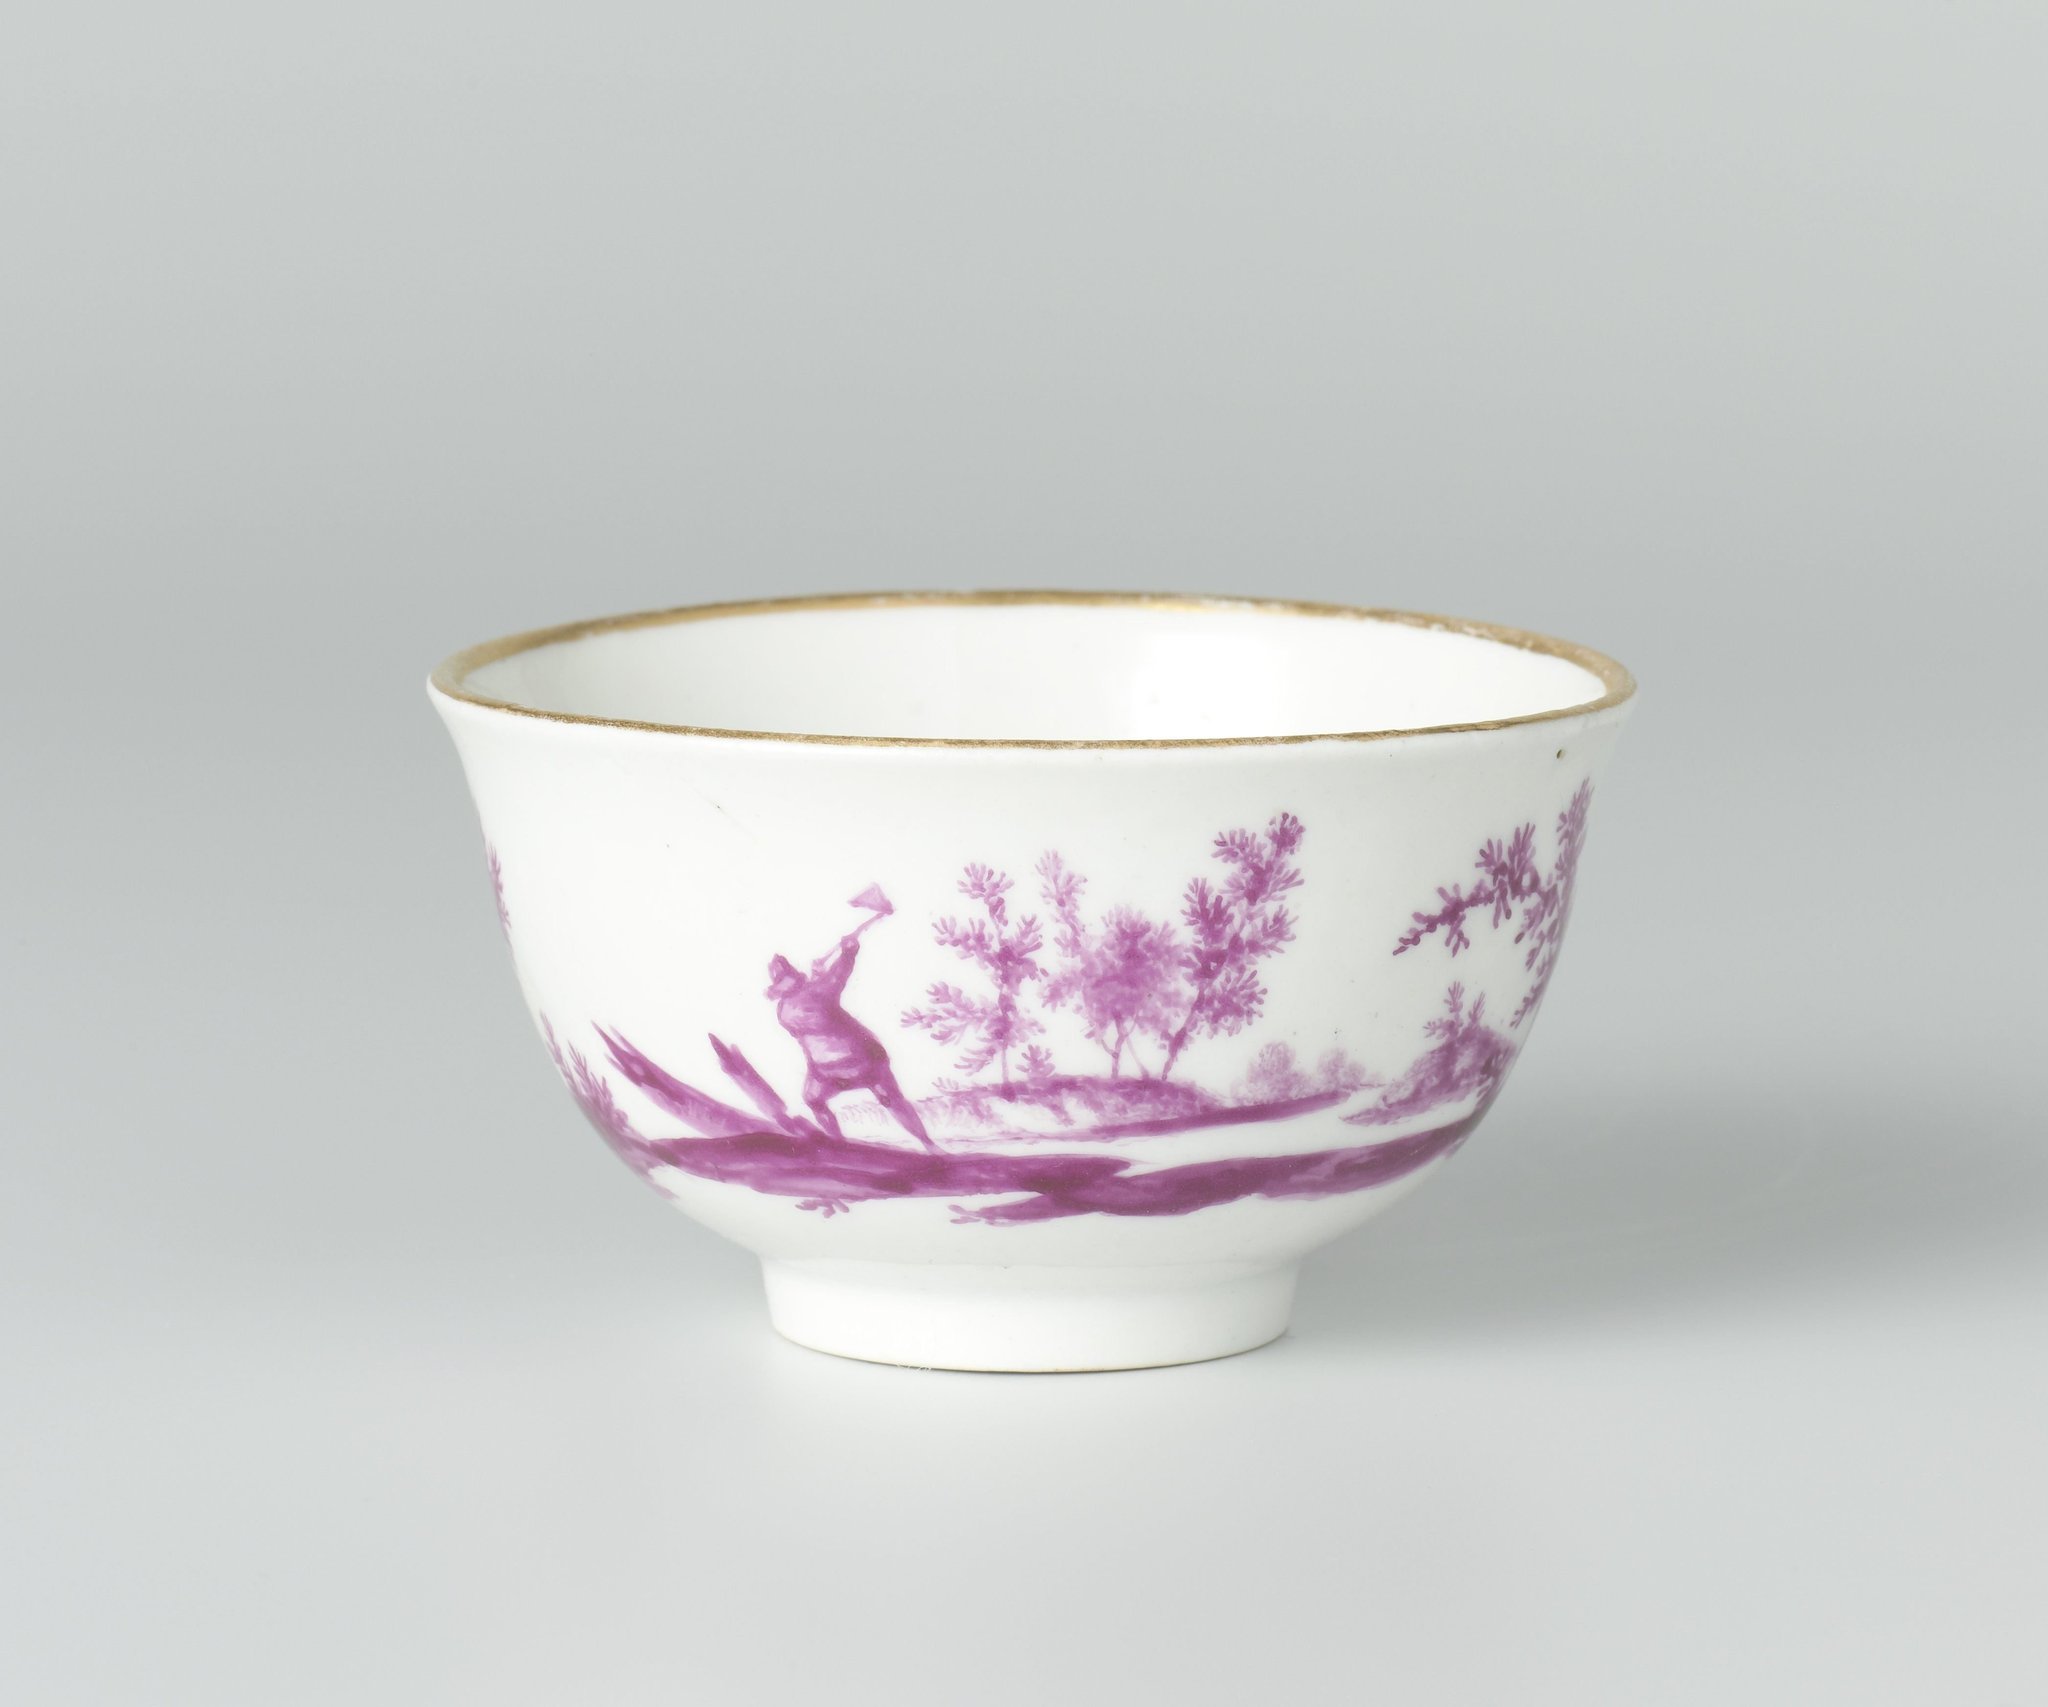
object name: cup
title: Theekop met figuren in landschap in bietenrood met gouden biezen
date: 1775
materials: porcelain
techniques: painted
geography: loosdrecht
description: Theekop van porselein, zonder oor. Beschilderd met figuren in een landschap in bietenrood en gouden biezen.